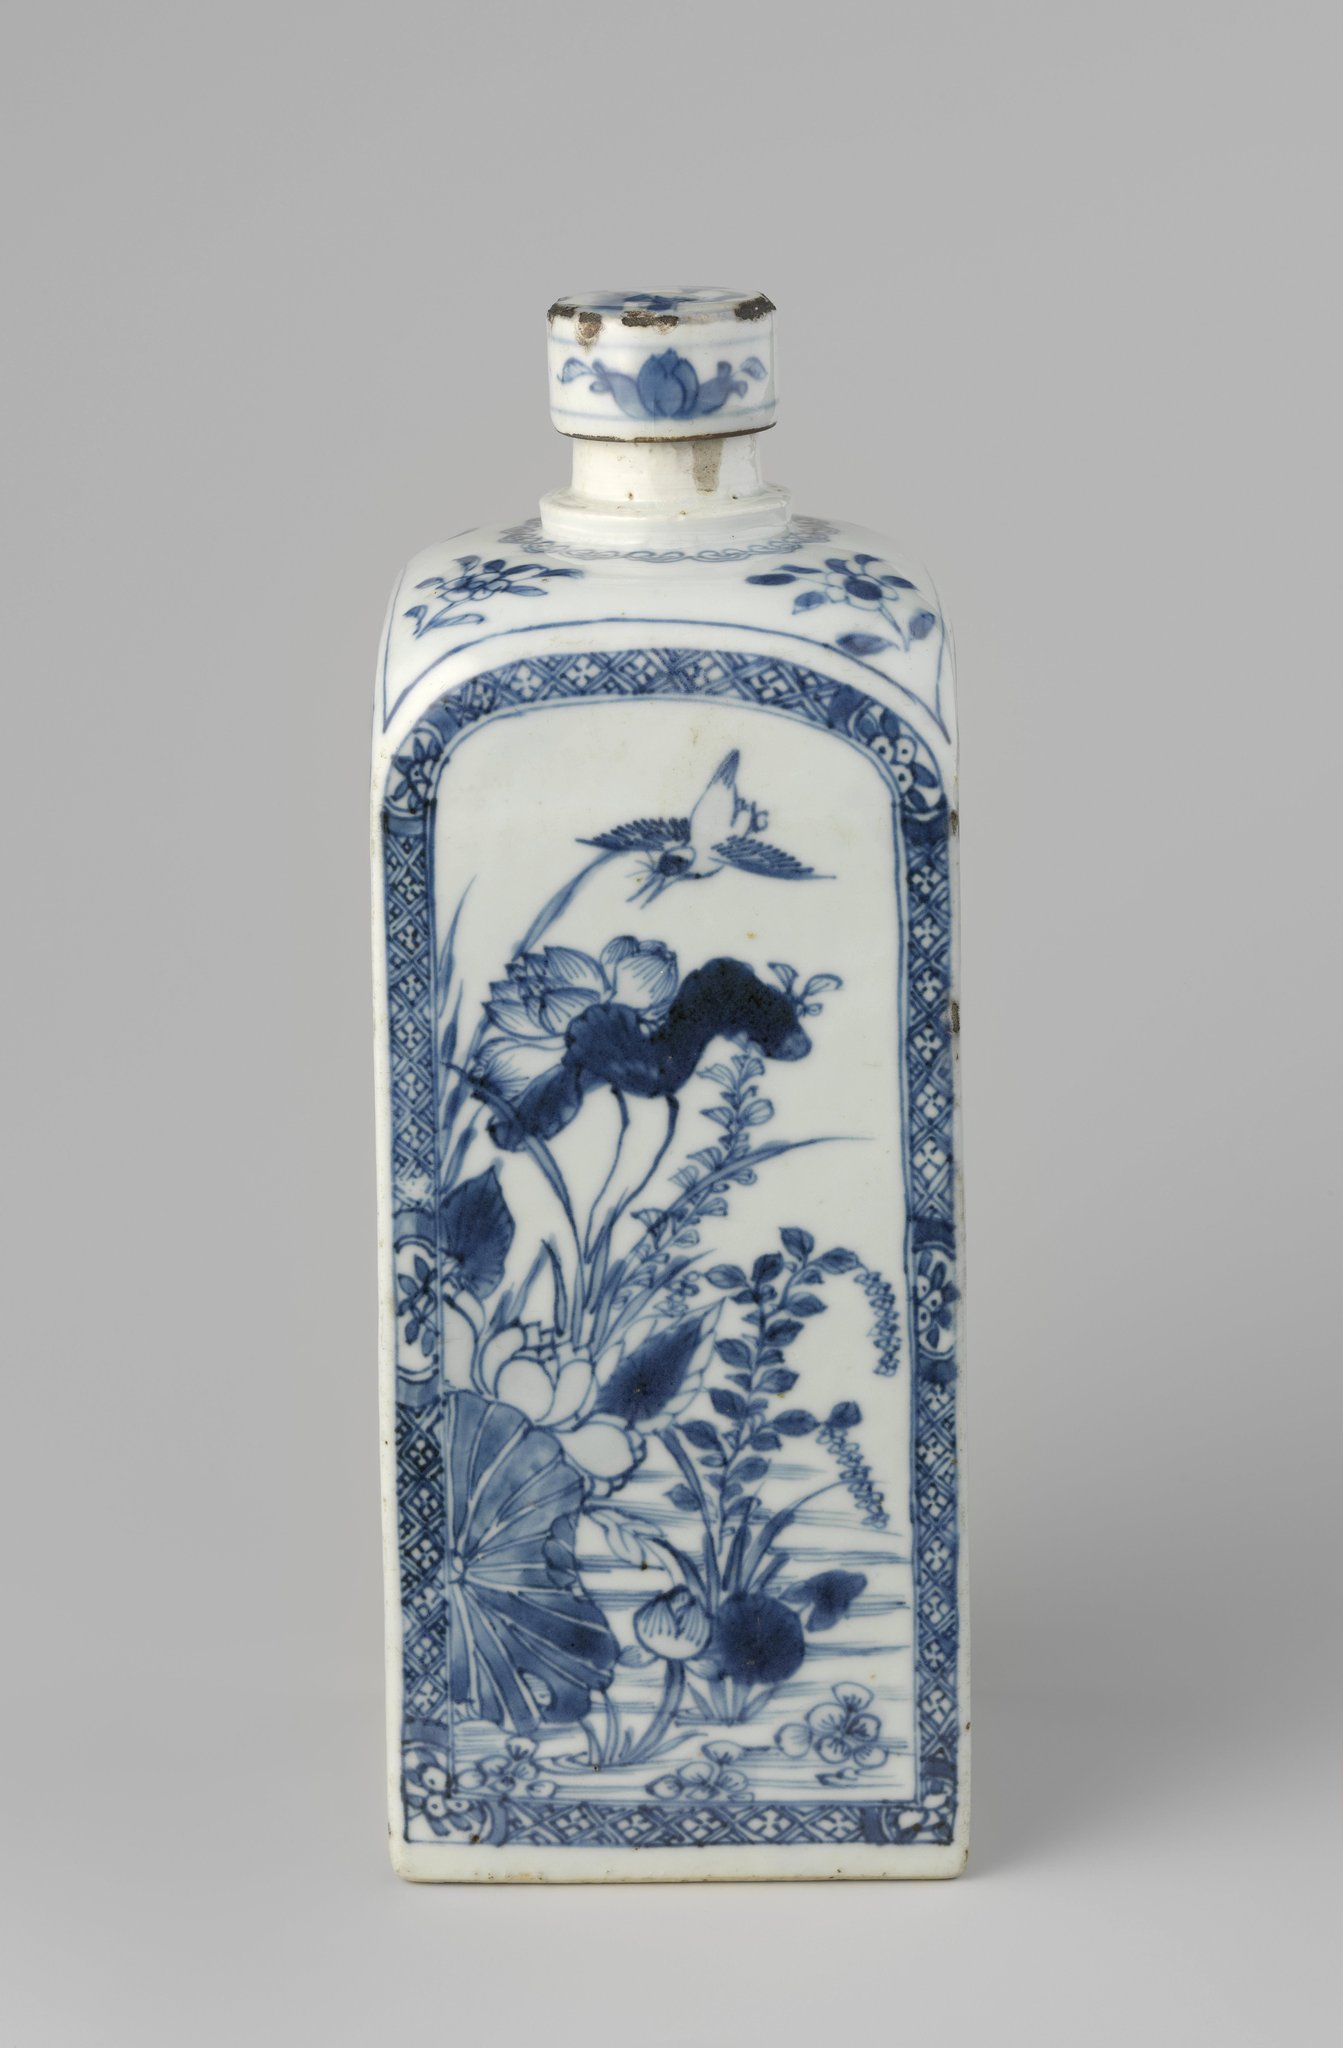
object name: bottle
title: Square bottle with flowering plants, rocks and birds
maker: Anonymous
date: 1680-1700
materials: cobalt, glaze, paint, porcelain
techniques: firing, forming, vitrification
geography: china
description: The form of this porcelain bottle is based on a European glass model. The square shape of such sturdy porcelain bottles was very practical on board VOC ships: it allowed them to be conveniently packed in chests called ‘kelders’ (cellars).